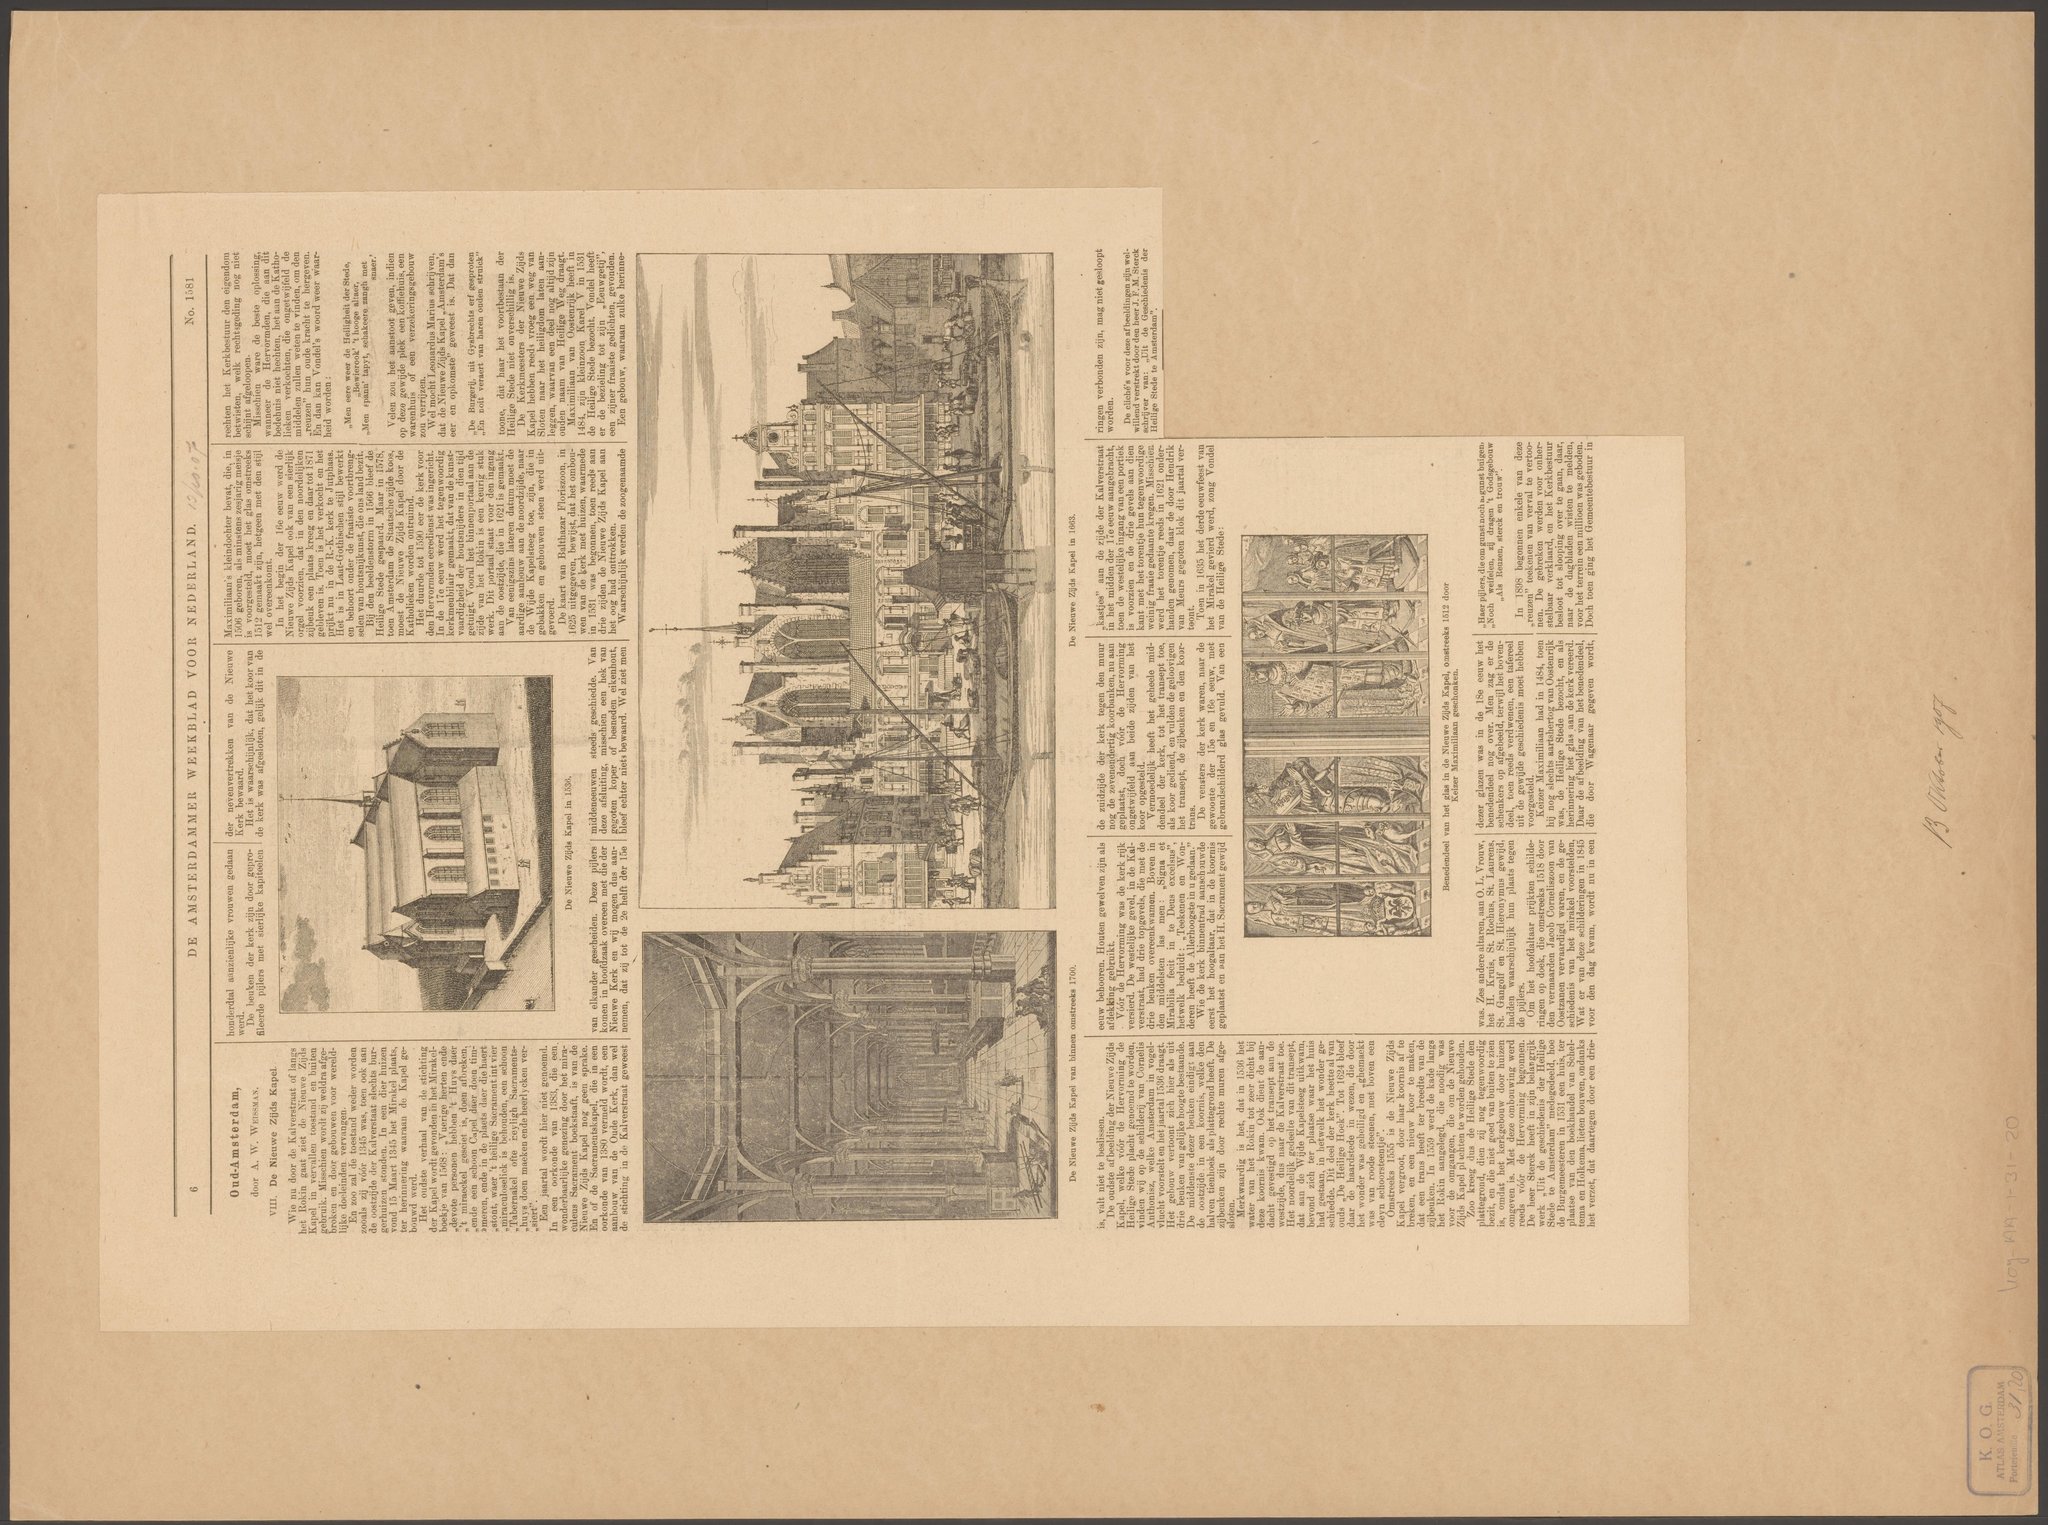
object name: article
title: Artikel over de Nieuwezijds Kapel te Amsterdam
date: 1907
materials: paper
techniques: letterpress printing, line block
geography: netherlands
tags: maria (hertogin van bourgondië), eleonora van oostenrijk (koningin van portugal en frankrijk), maximilian i (holy roman emperor), bruges, filips de schone (hertog van bourgondië), ghent, charles v (holy roman emperor and king of spain), vienna, ferdinand i van habsburg (duits keizer), brussels, maria van hongarije (landvoogdes der nederlanden), sailing-ship, sailing-boat, church-window, e.g. rose-window, interior of church, church (exterior) - qq - small church, chapel, canals, waters (in city) (+ city(-scape) with figures, staffage)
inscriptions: collector's mark: Lugt 1641b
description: Onderwerpsrubriek binnen de Atlas Amsterdam: Kerkwezen: Hervormde Gemeente: Nieuwezijds Kapel.